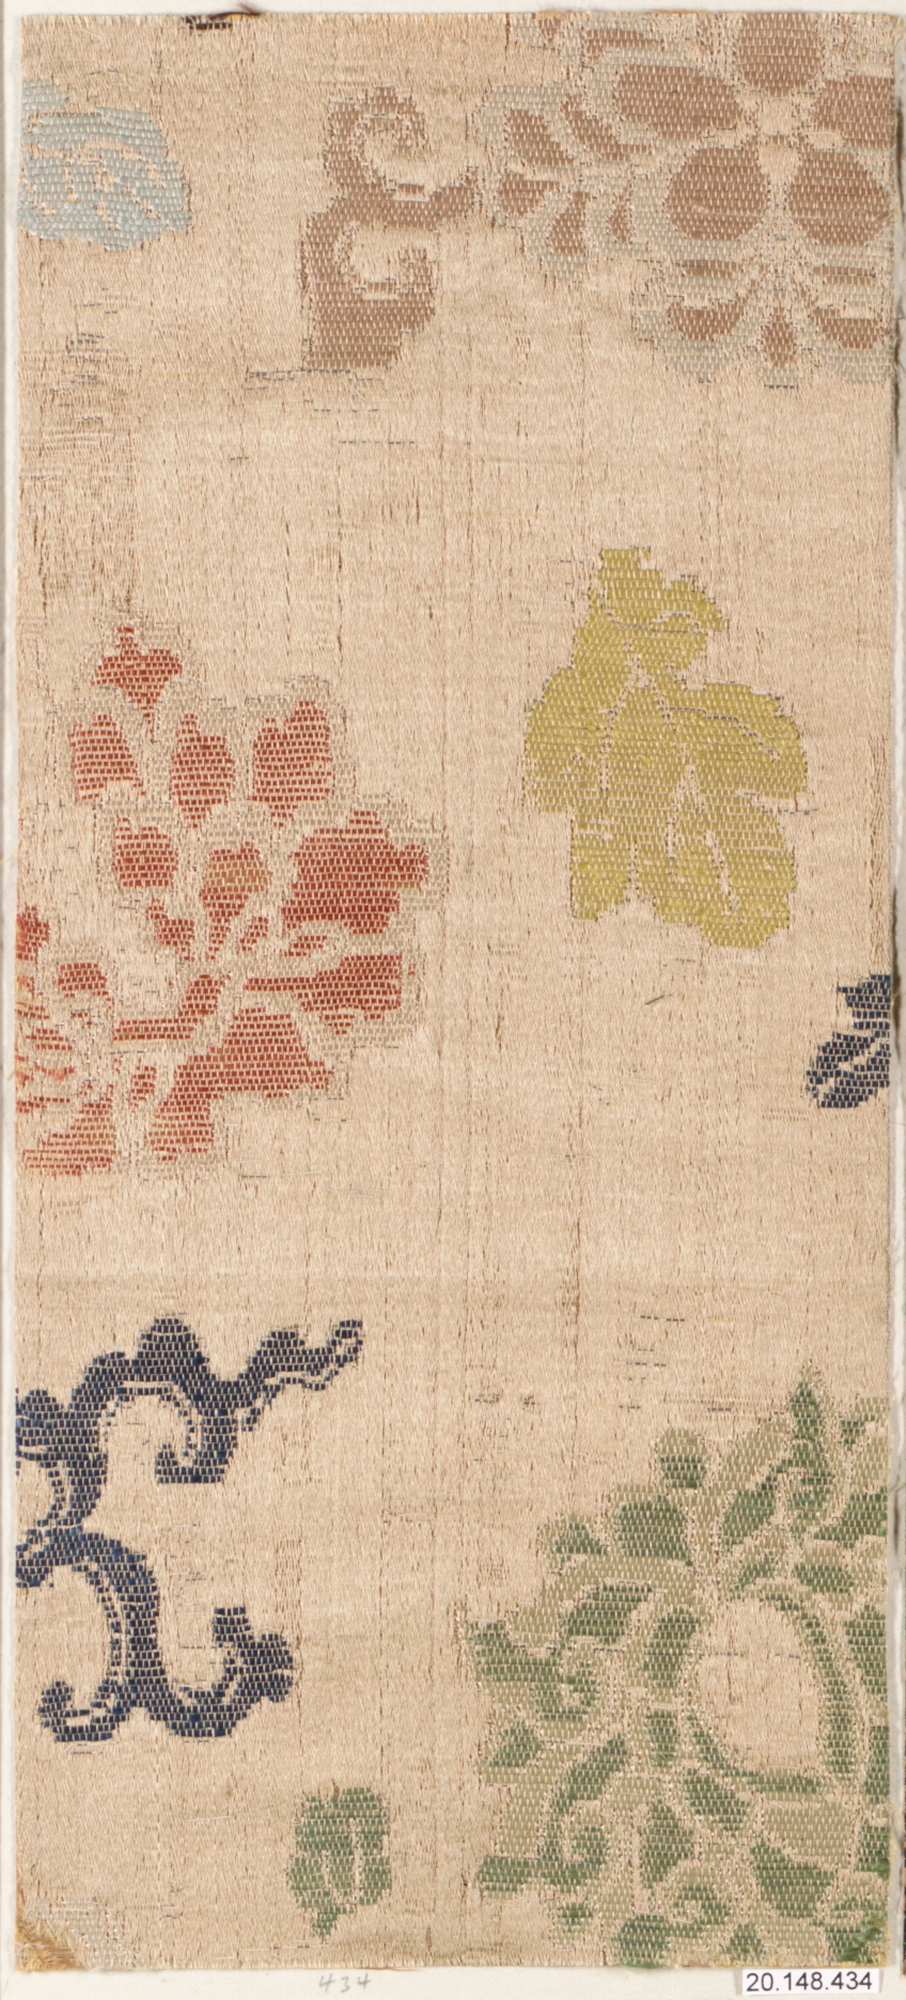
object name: piece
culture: chinese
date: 1701-1800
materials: silk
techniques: compound weave